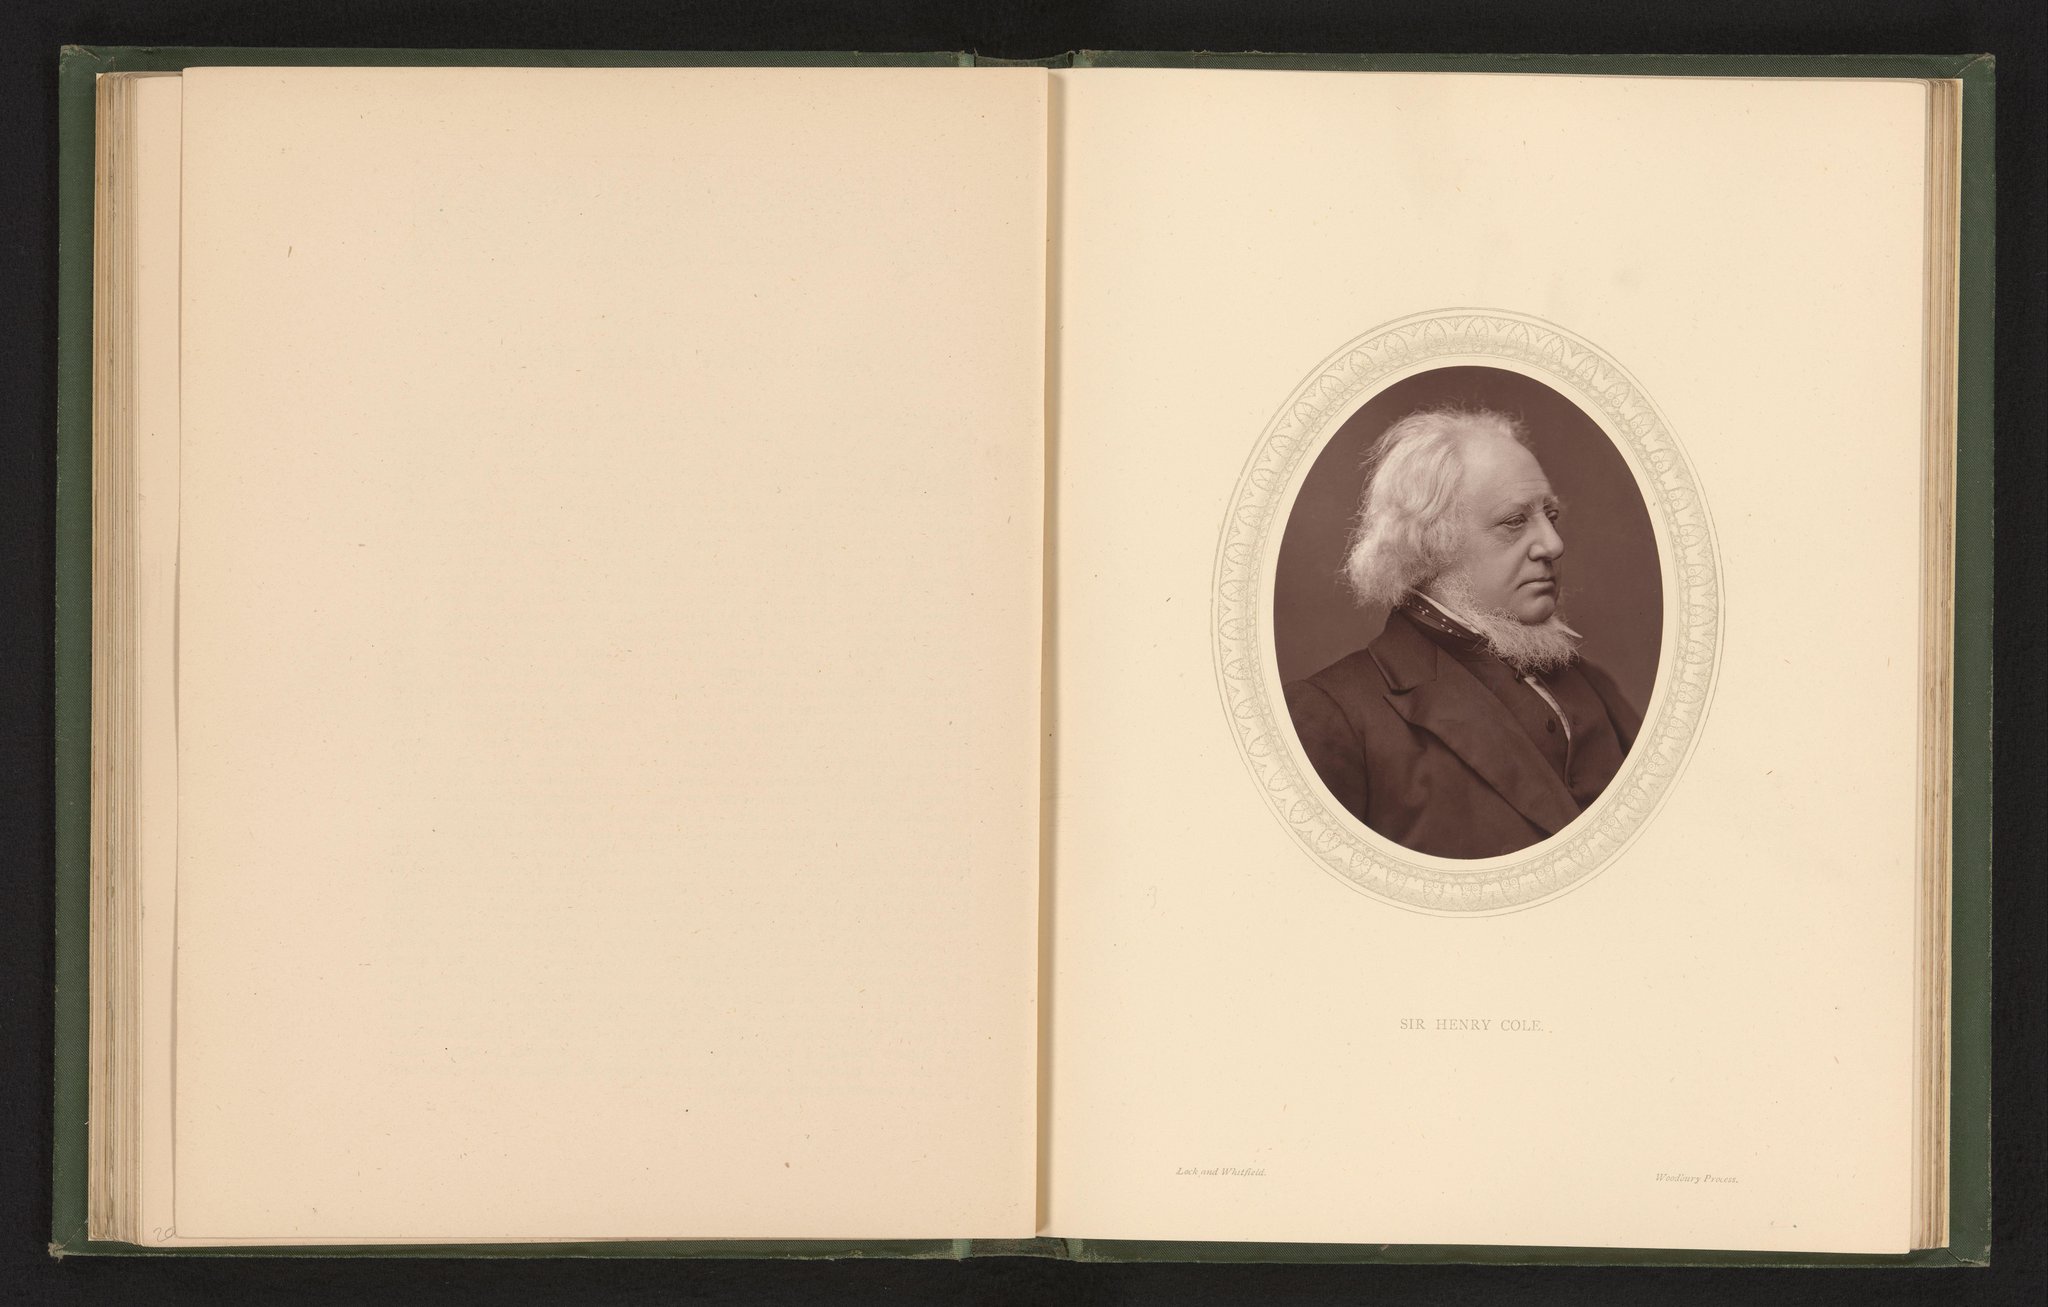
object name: photomechanical print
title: Sir Henry Cole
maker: Anonymous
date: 1872-1877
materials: paper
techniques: woodburytype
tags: designer, historical persons (portraits and scenes from the life) (+ (full) bust portrait), magistracy, judges